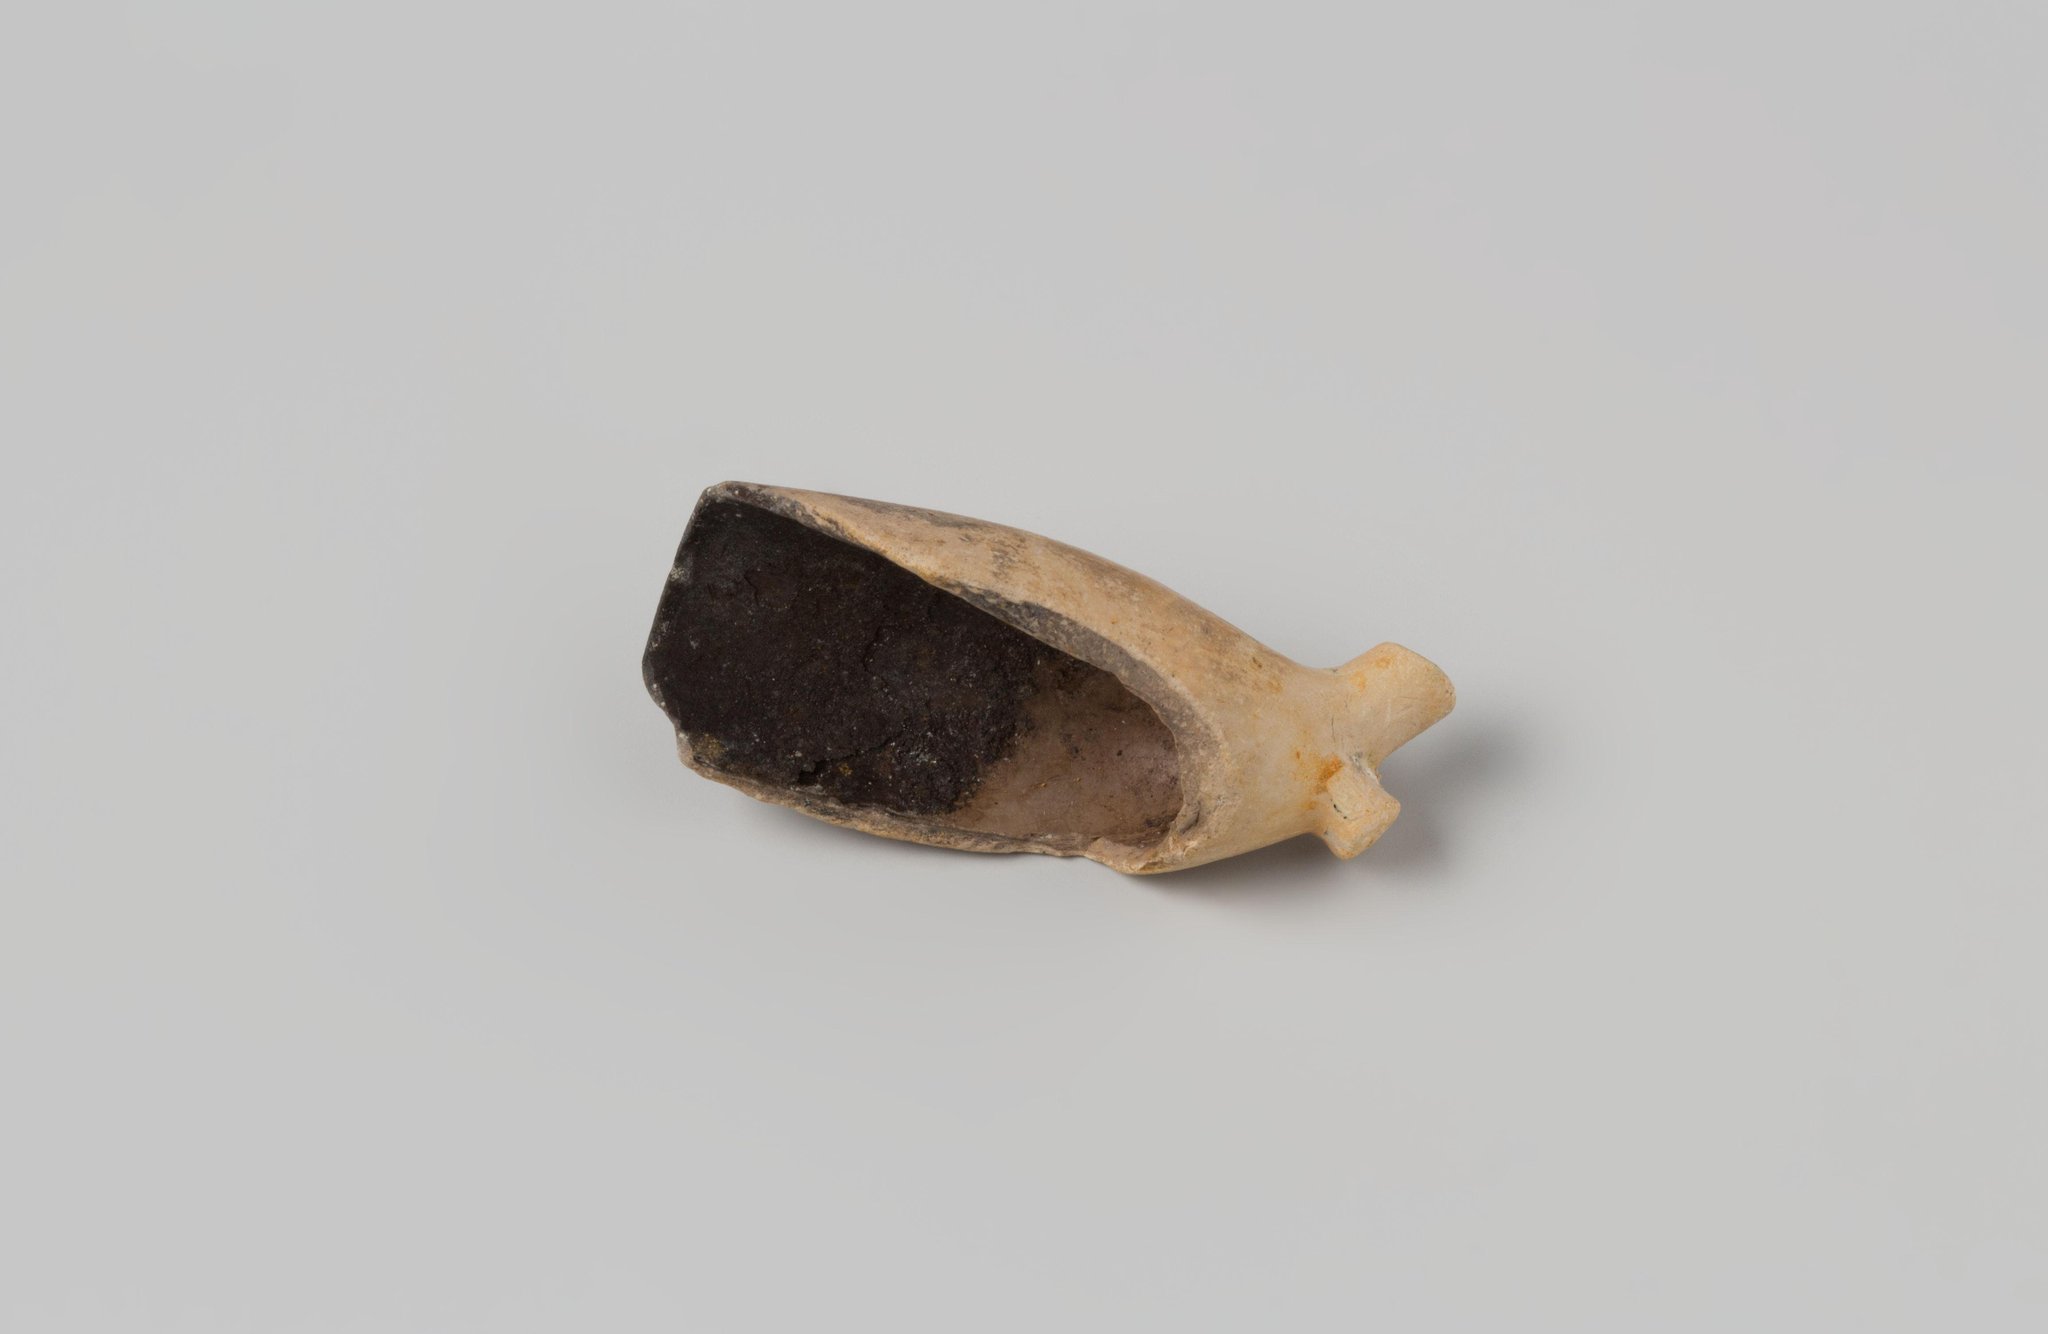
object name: pipe bowl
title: Fragment pijpenkop uit het wrak van de Oost-Indiëvaarder Hollandia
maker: Anonymous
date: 1700-1743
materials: clay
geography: netherlands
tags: verenigde oostindische compagnie, hollandia (schip), annet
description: Pipe, bowl, heelmark; fragm, 1hsm1, inside burned (used).